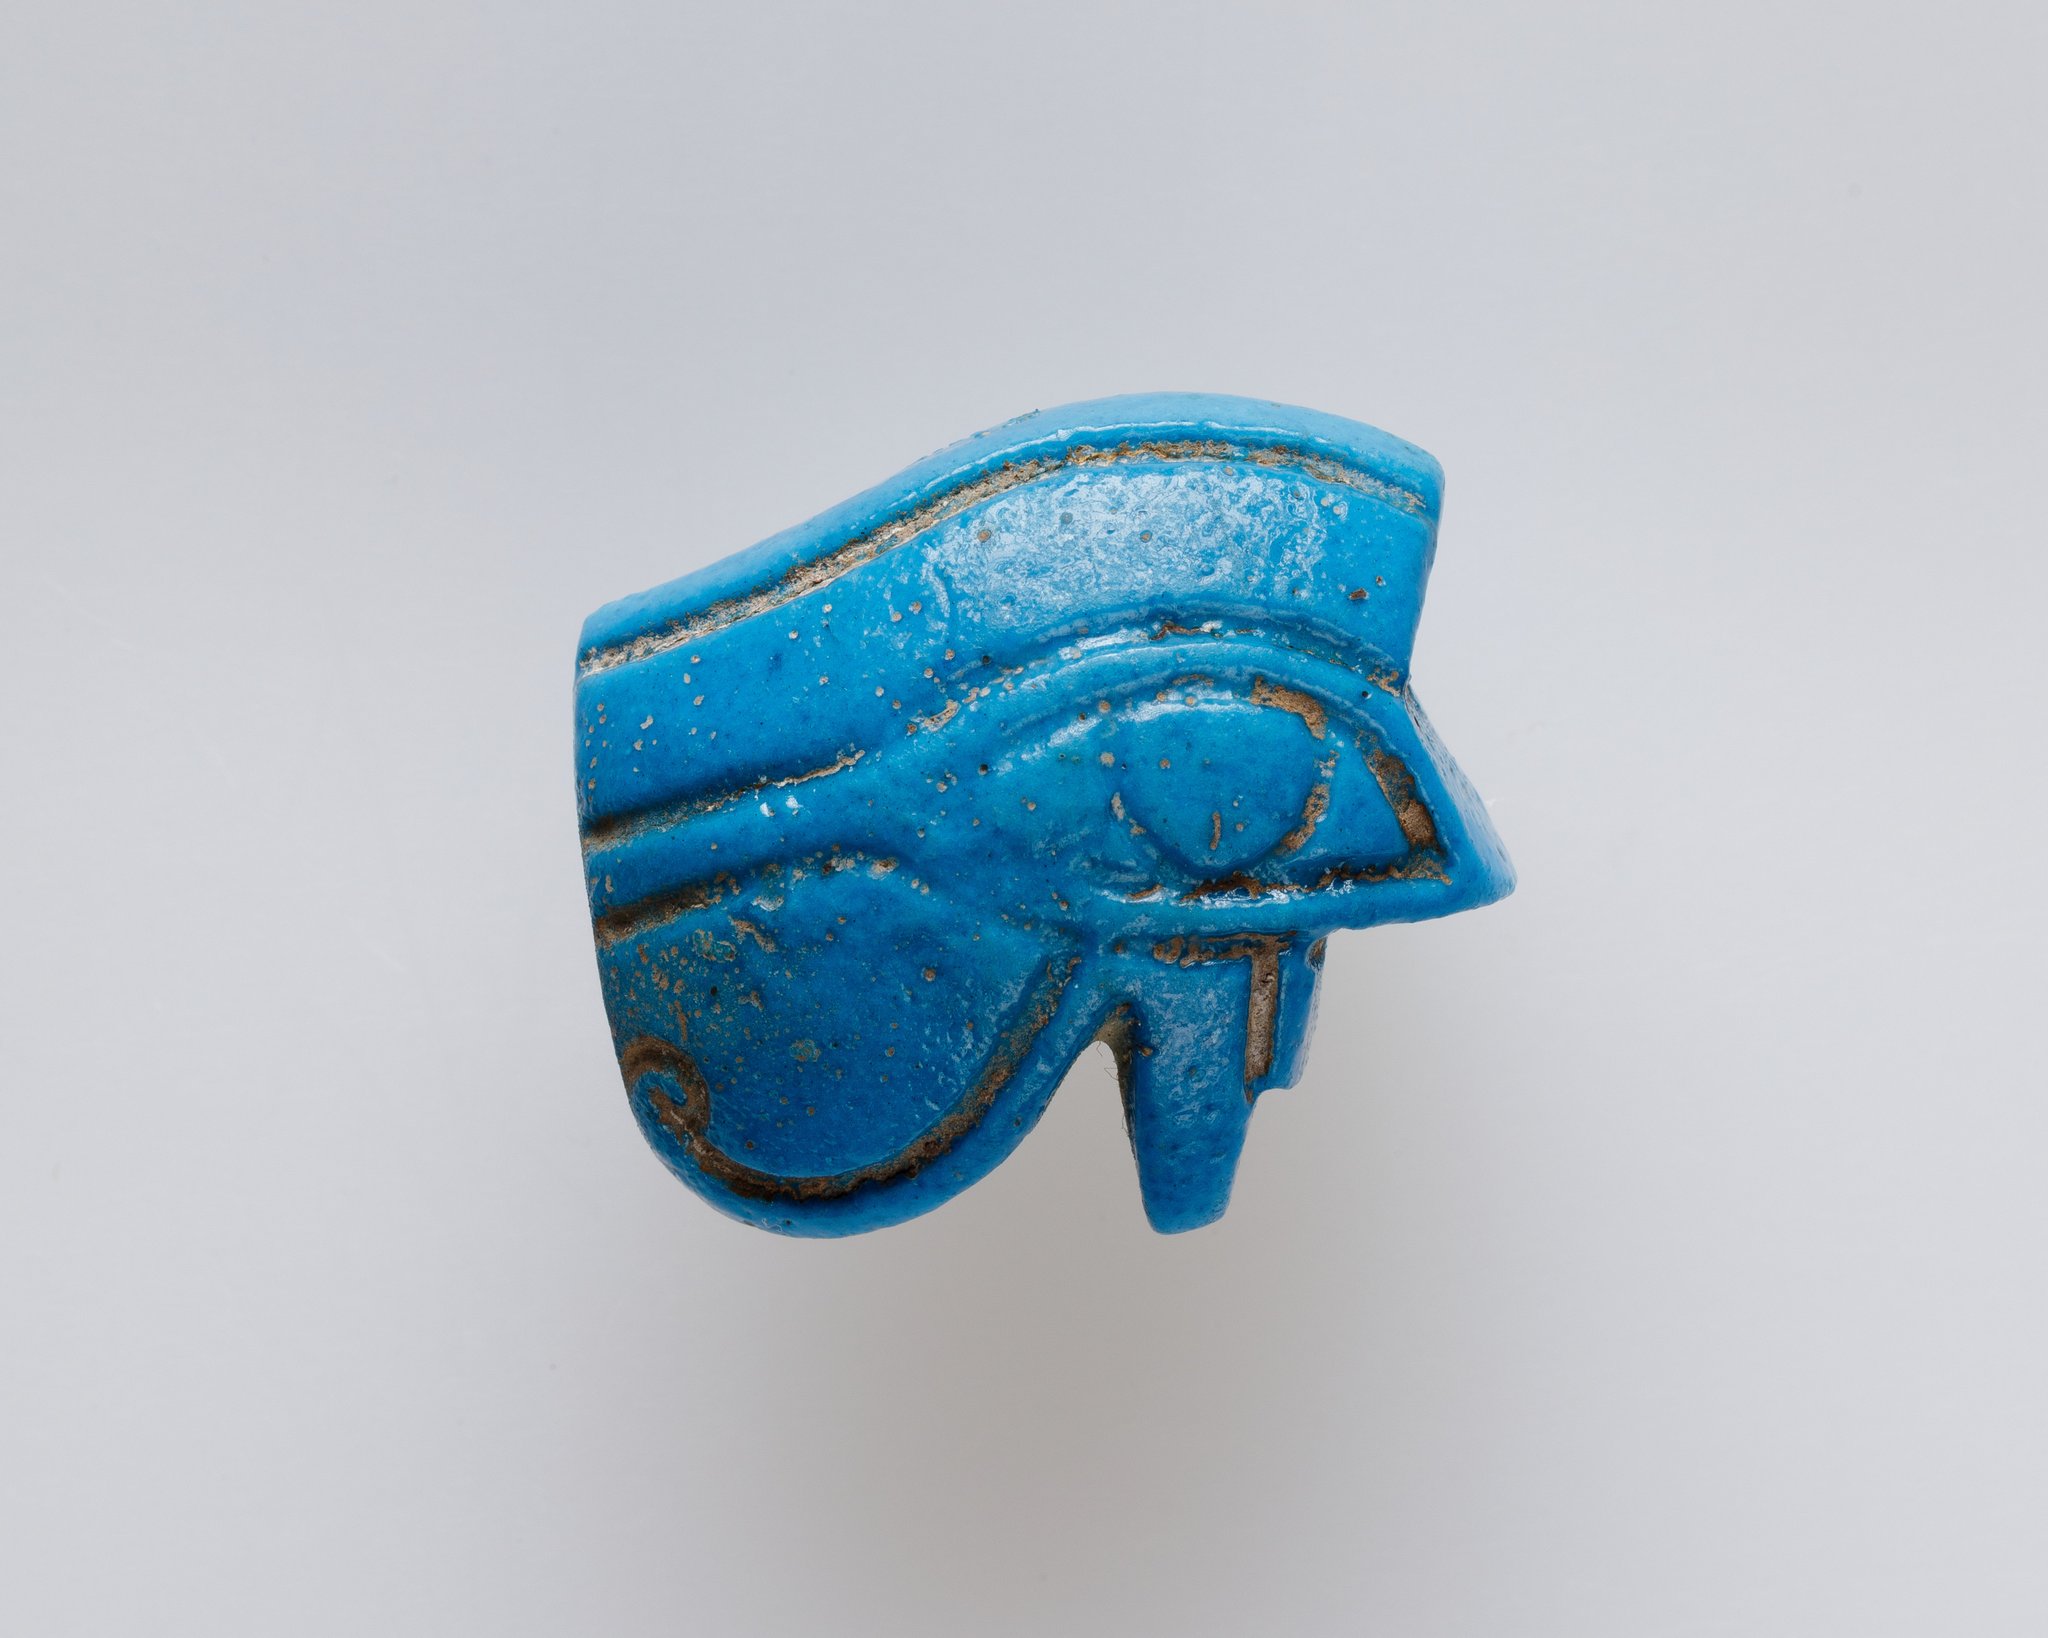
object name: amulet, wedjat eye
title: Wedjat Eye Amulet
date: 1070-343 BCE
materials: faience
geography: egypt